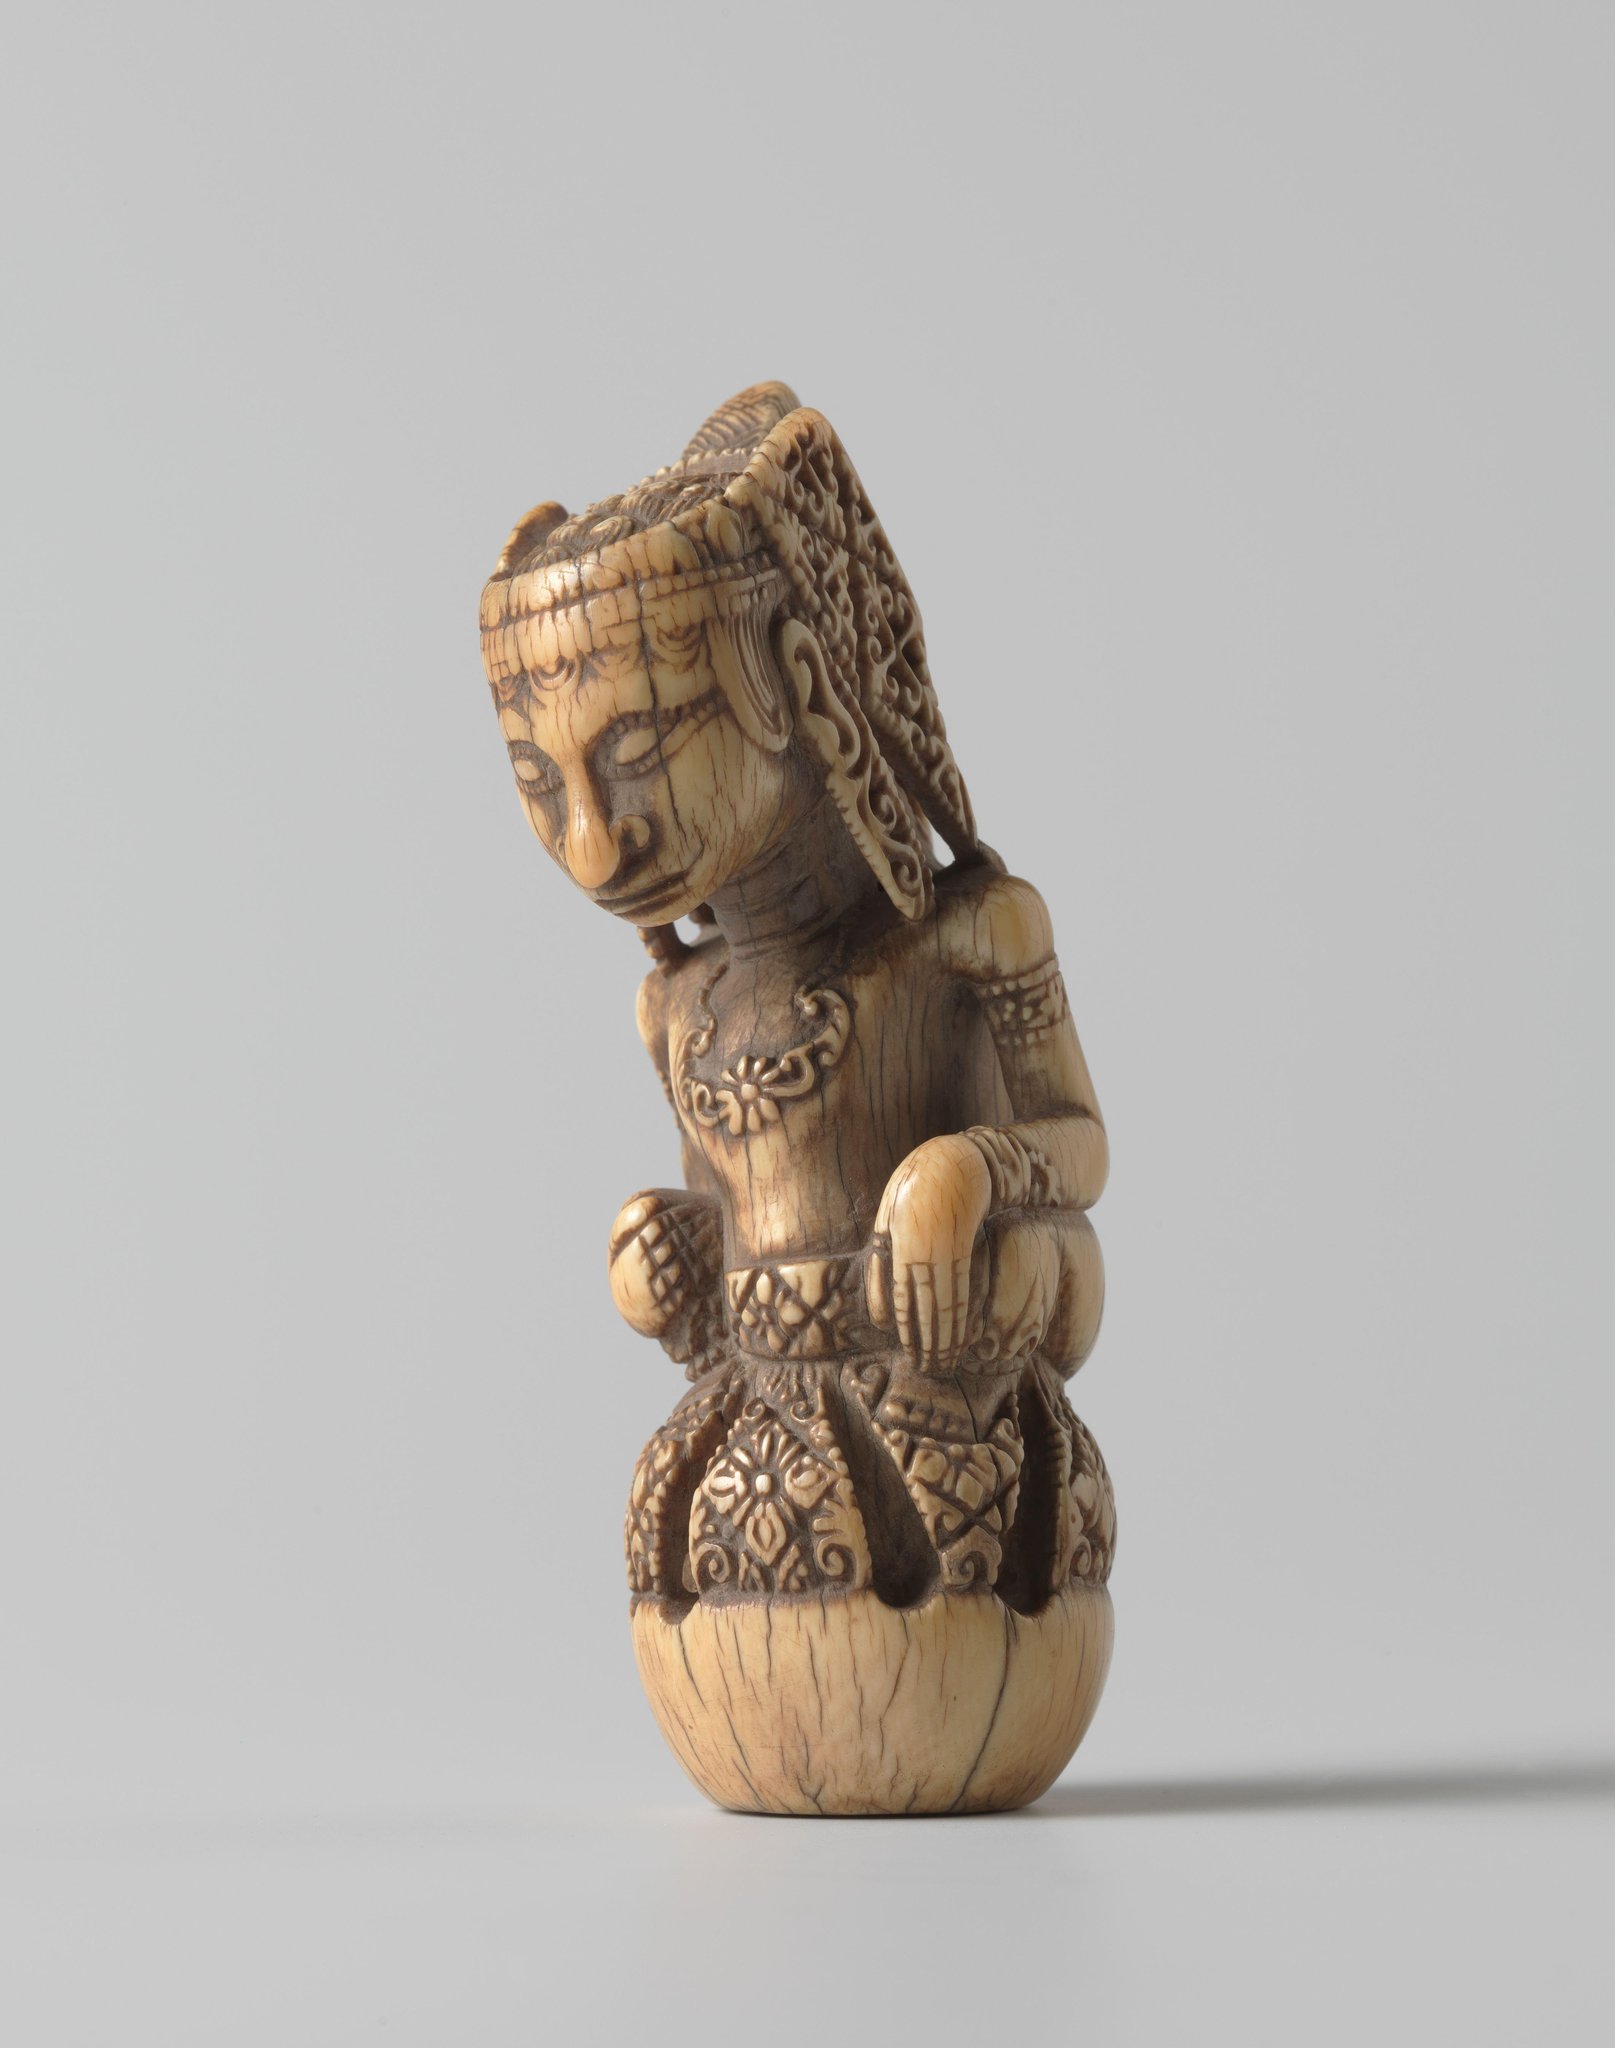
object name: kris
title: Balische krisgreep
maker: Anonymous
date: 1500-1700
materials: ivory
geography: bali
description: Krisgreep in de vorm van een mensenfiguur.